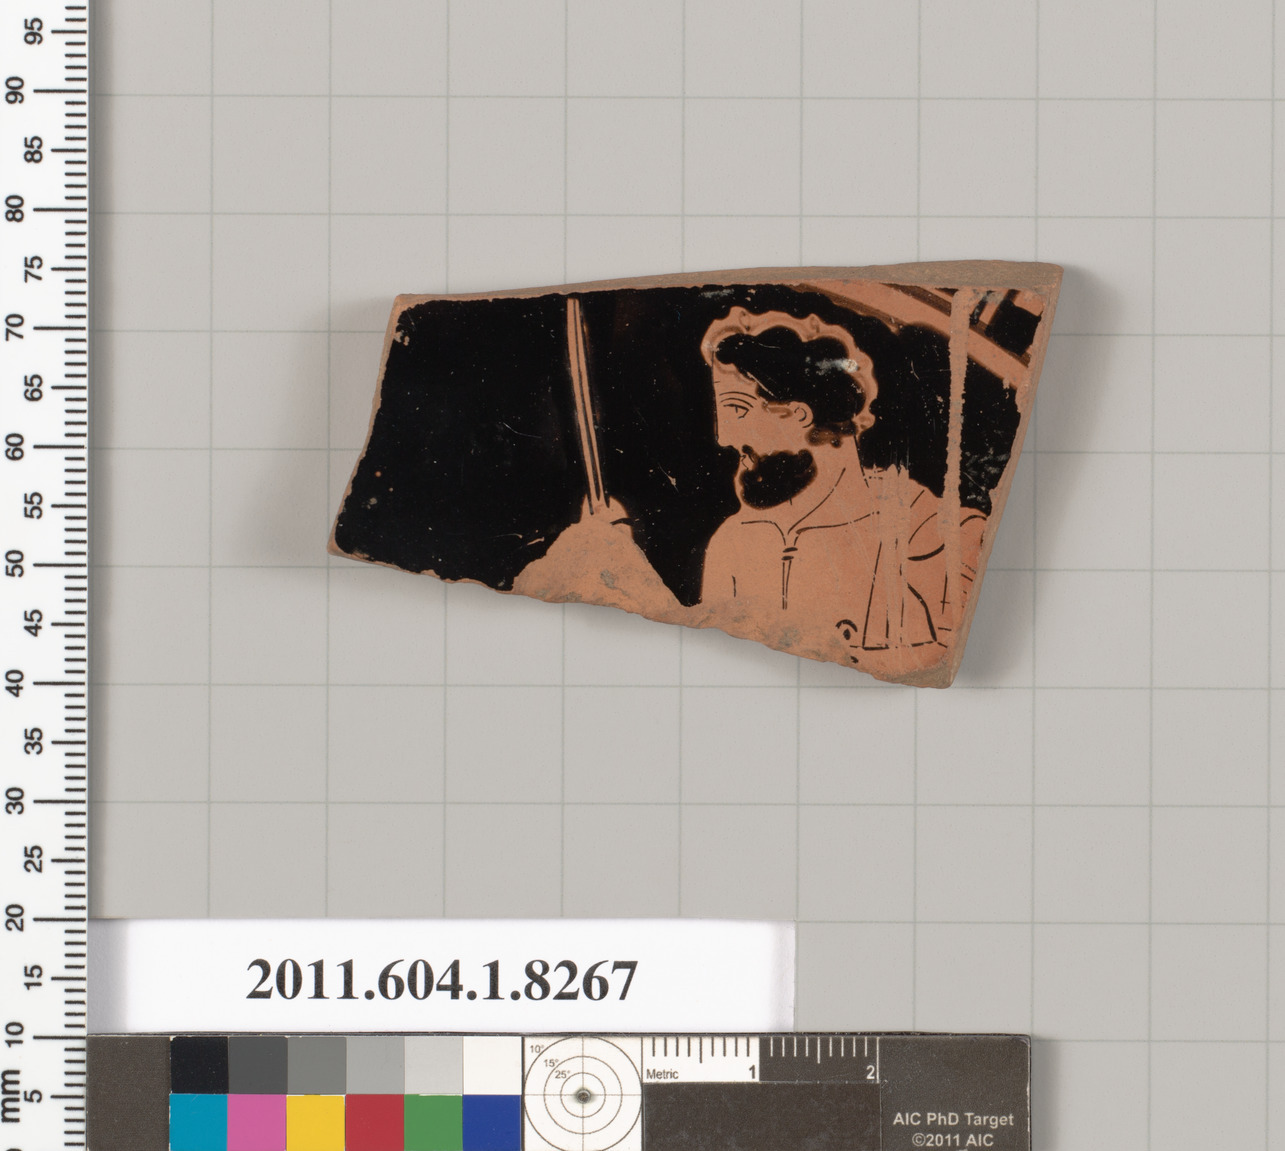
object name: kylix fragment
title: Terracotta fragment of a kylix (drinking cup)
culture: greek, attic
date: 410-400 BCE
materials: terracotta